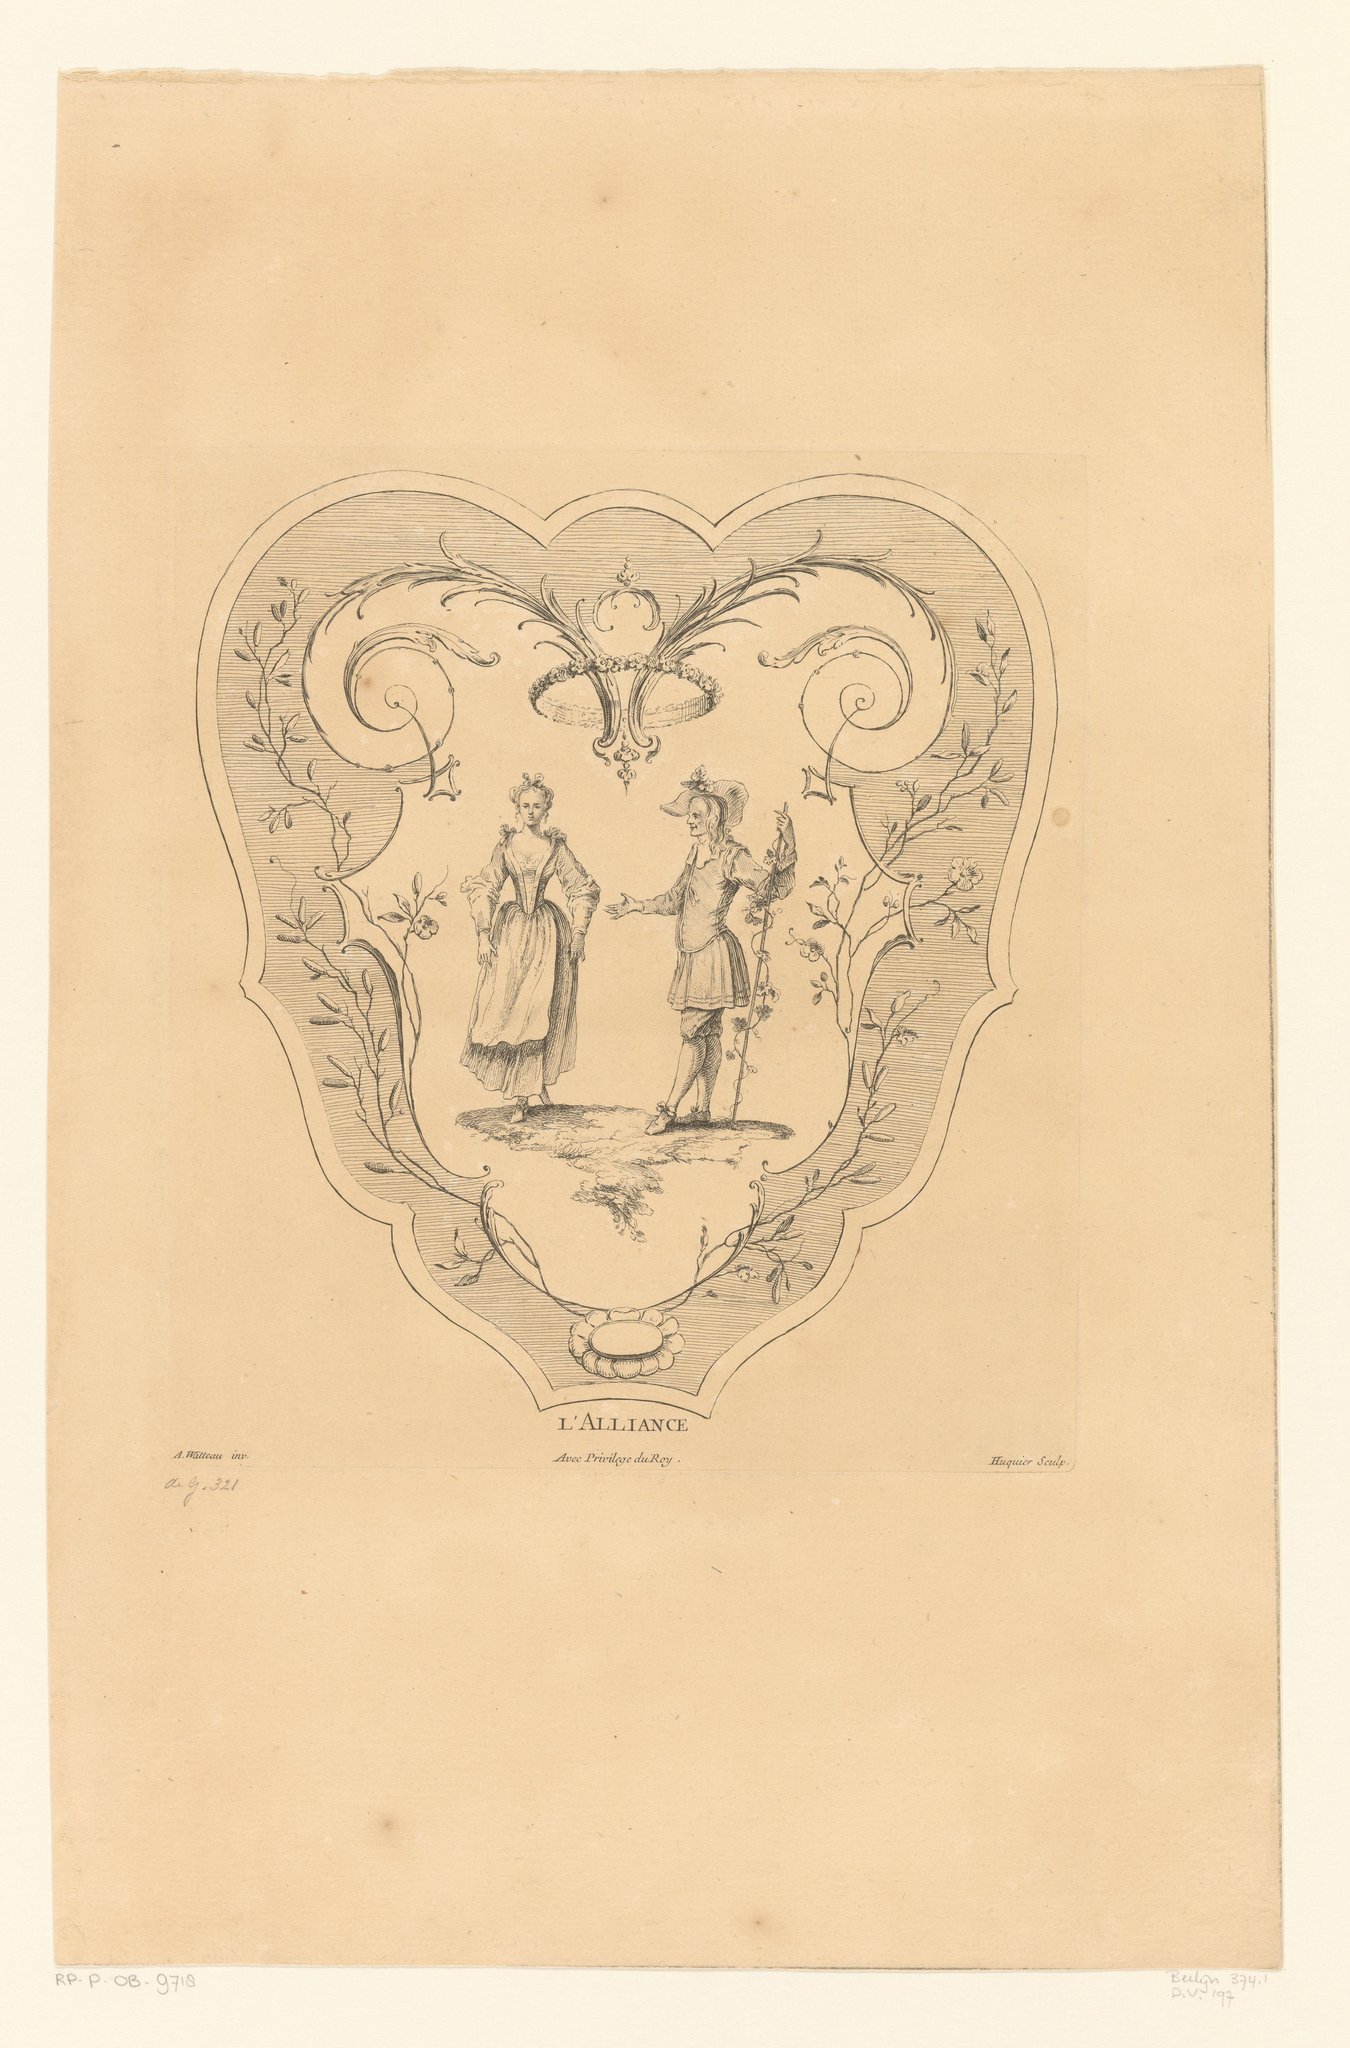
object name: ornament print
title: Vrouw en man met wijnstok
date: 1729-1737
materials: paper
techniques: etching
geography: paris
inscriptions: collector's mark: Lugt 2228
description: Hartvormige omlijsting met een vrouw en een man met een wijnstok. De man reikt zijn hand uit naar de vrouw.